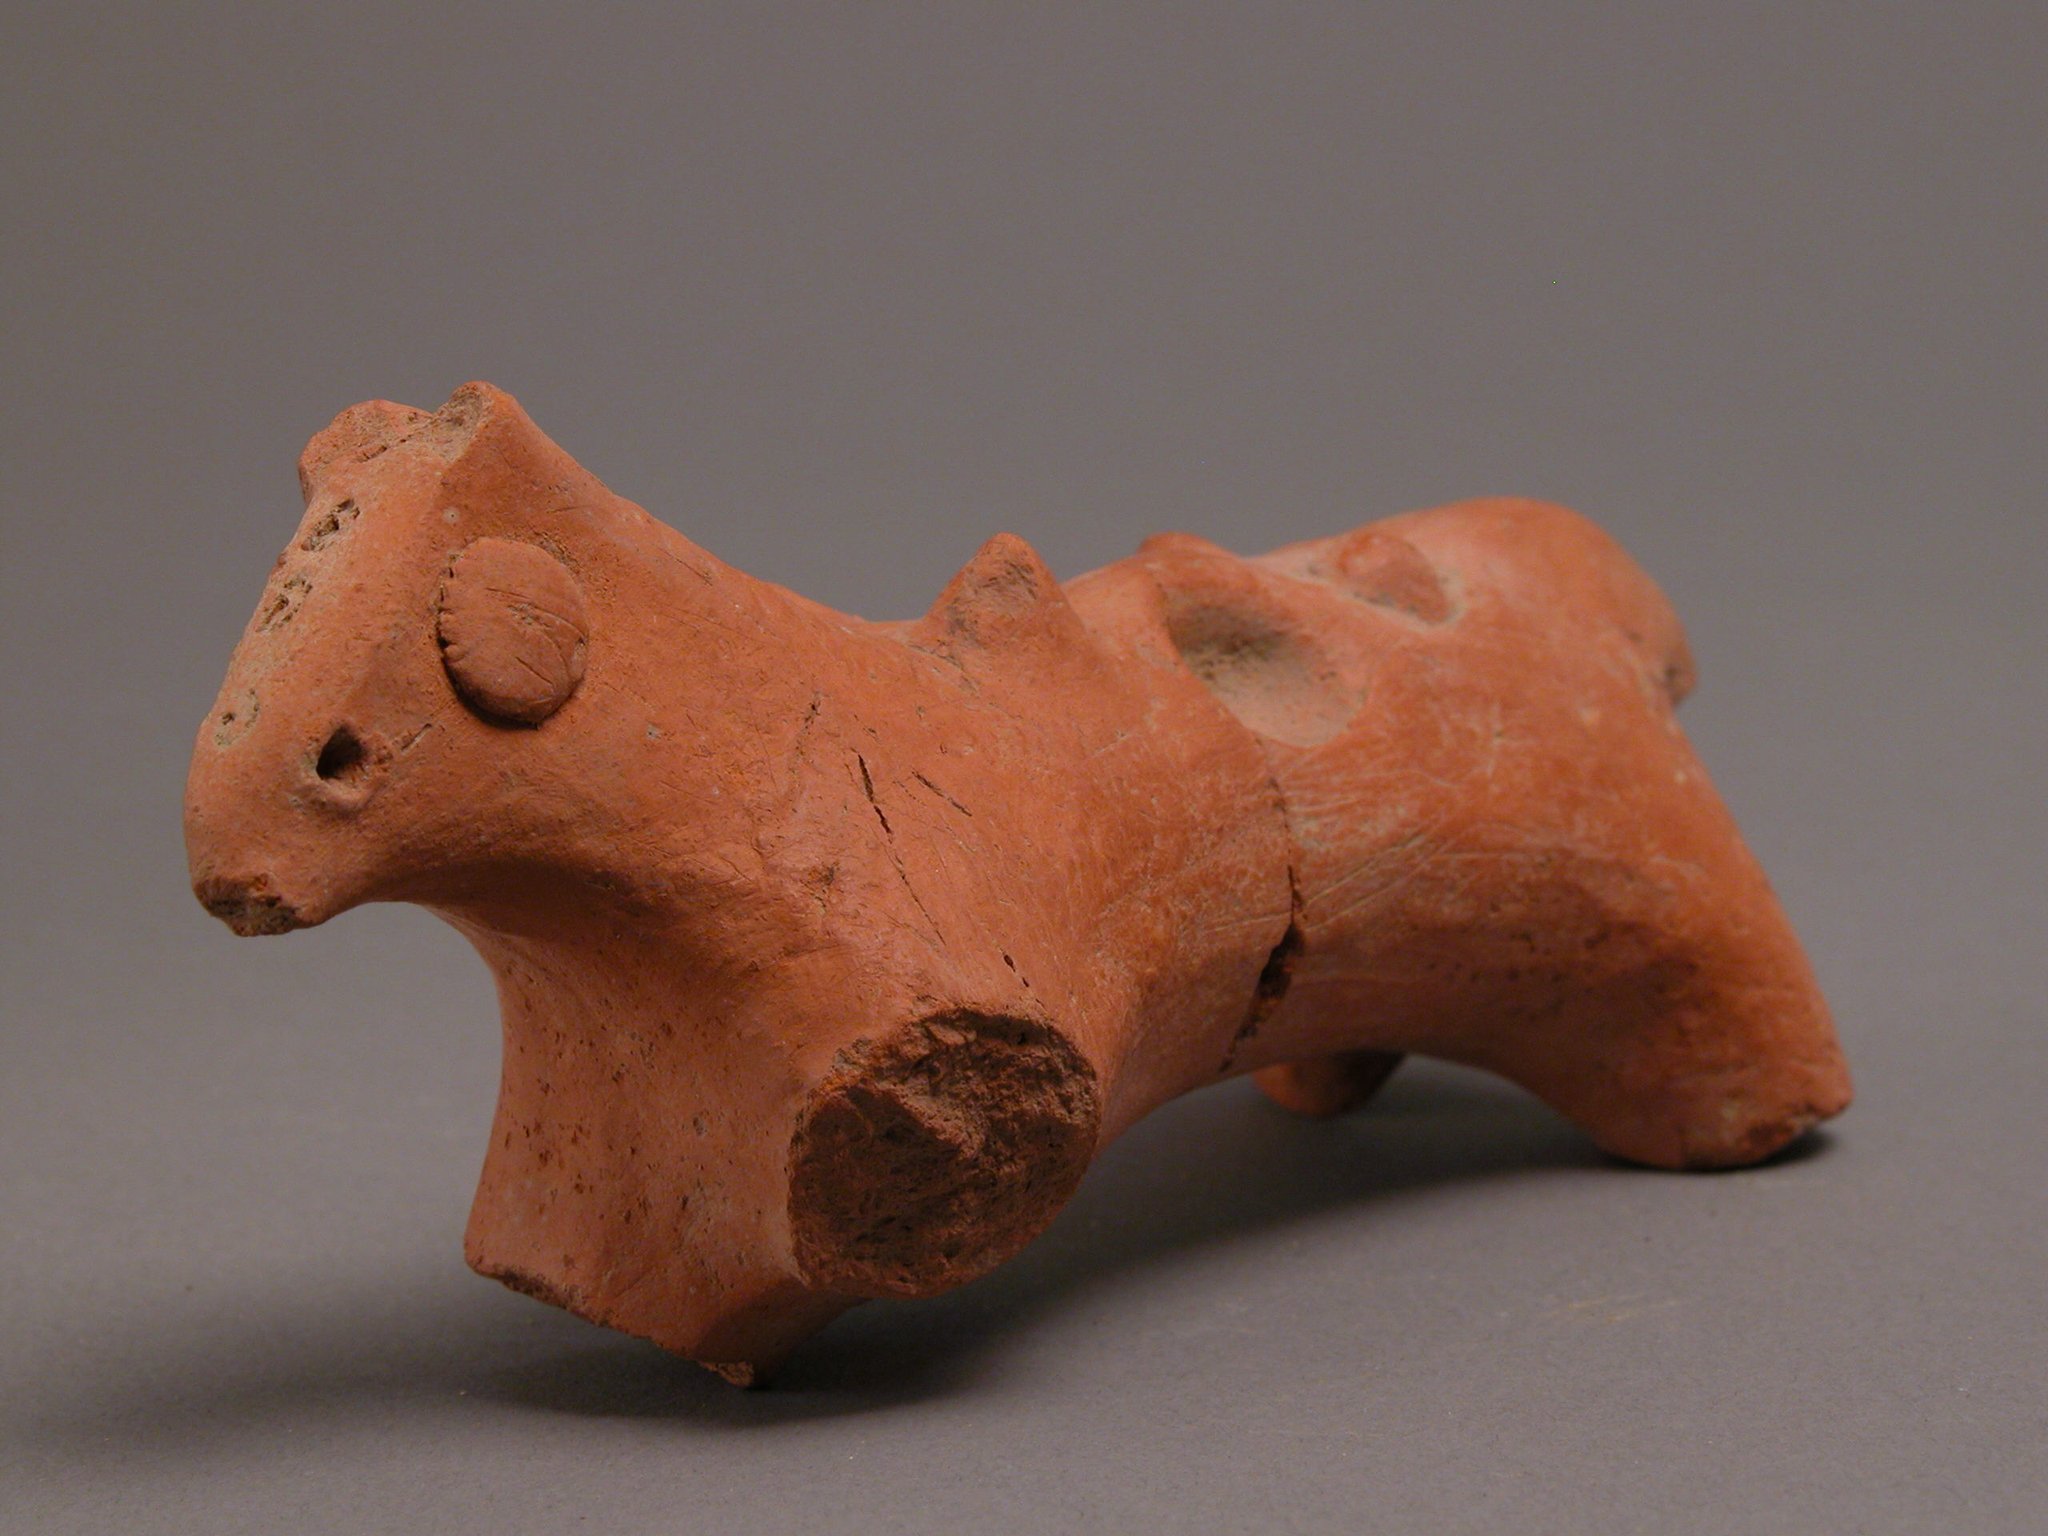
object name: statuette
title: Animal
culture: coptic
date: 301-700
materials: earthenware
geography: egypt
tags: animals